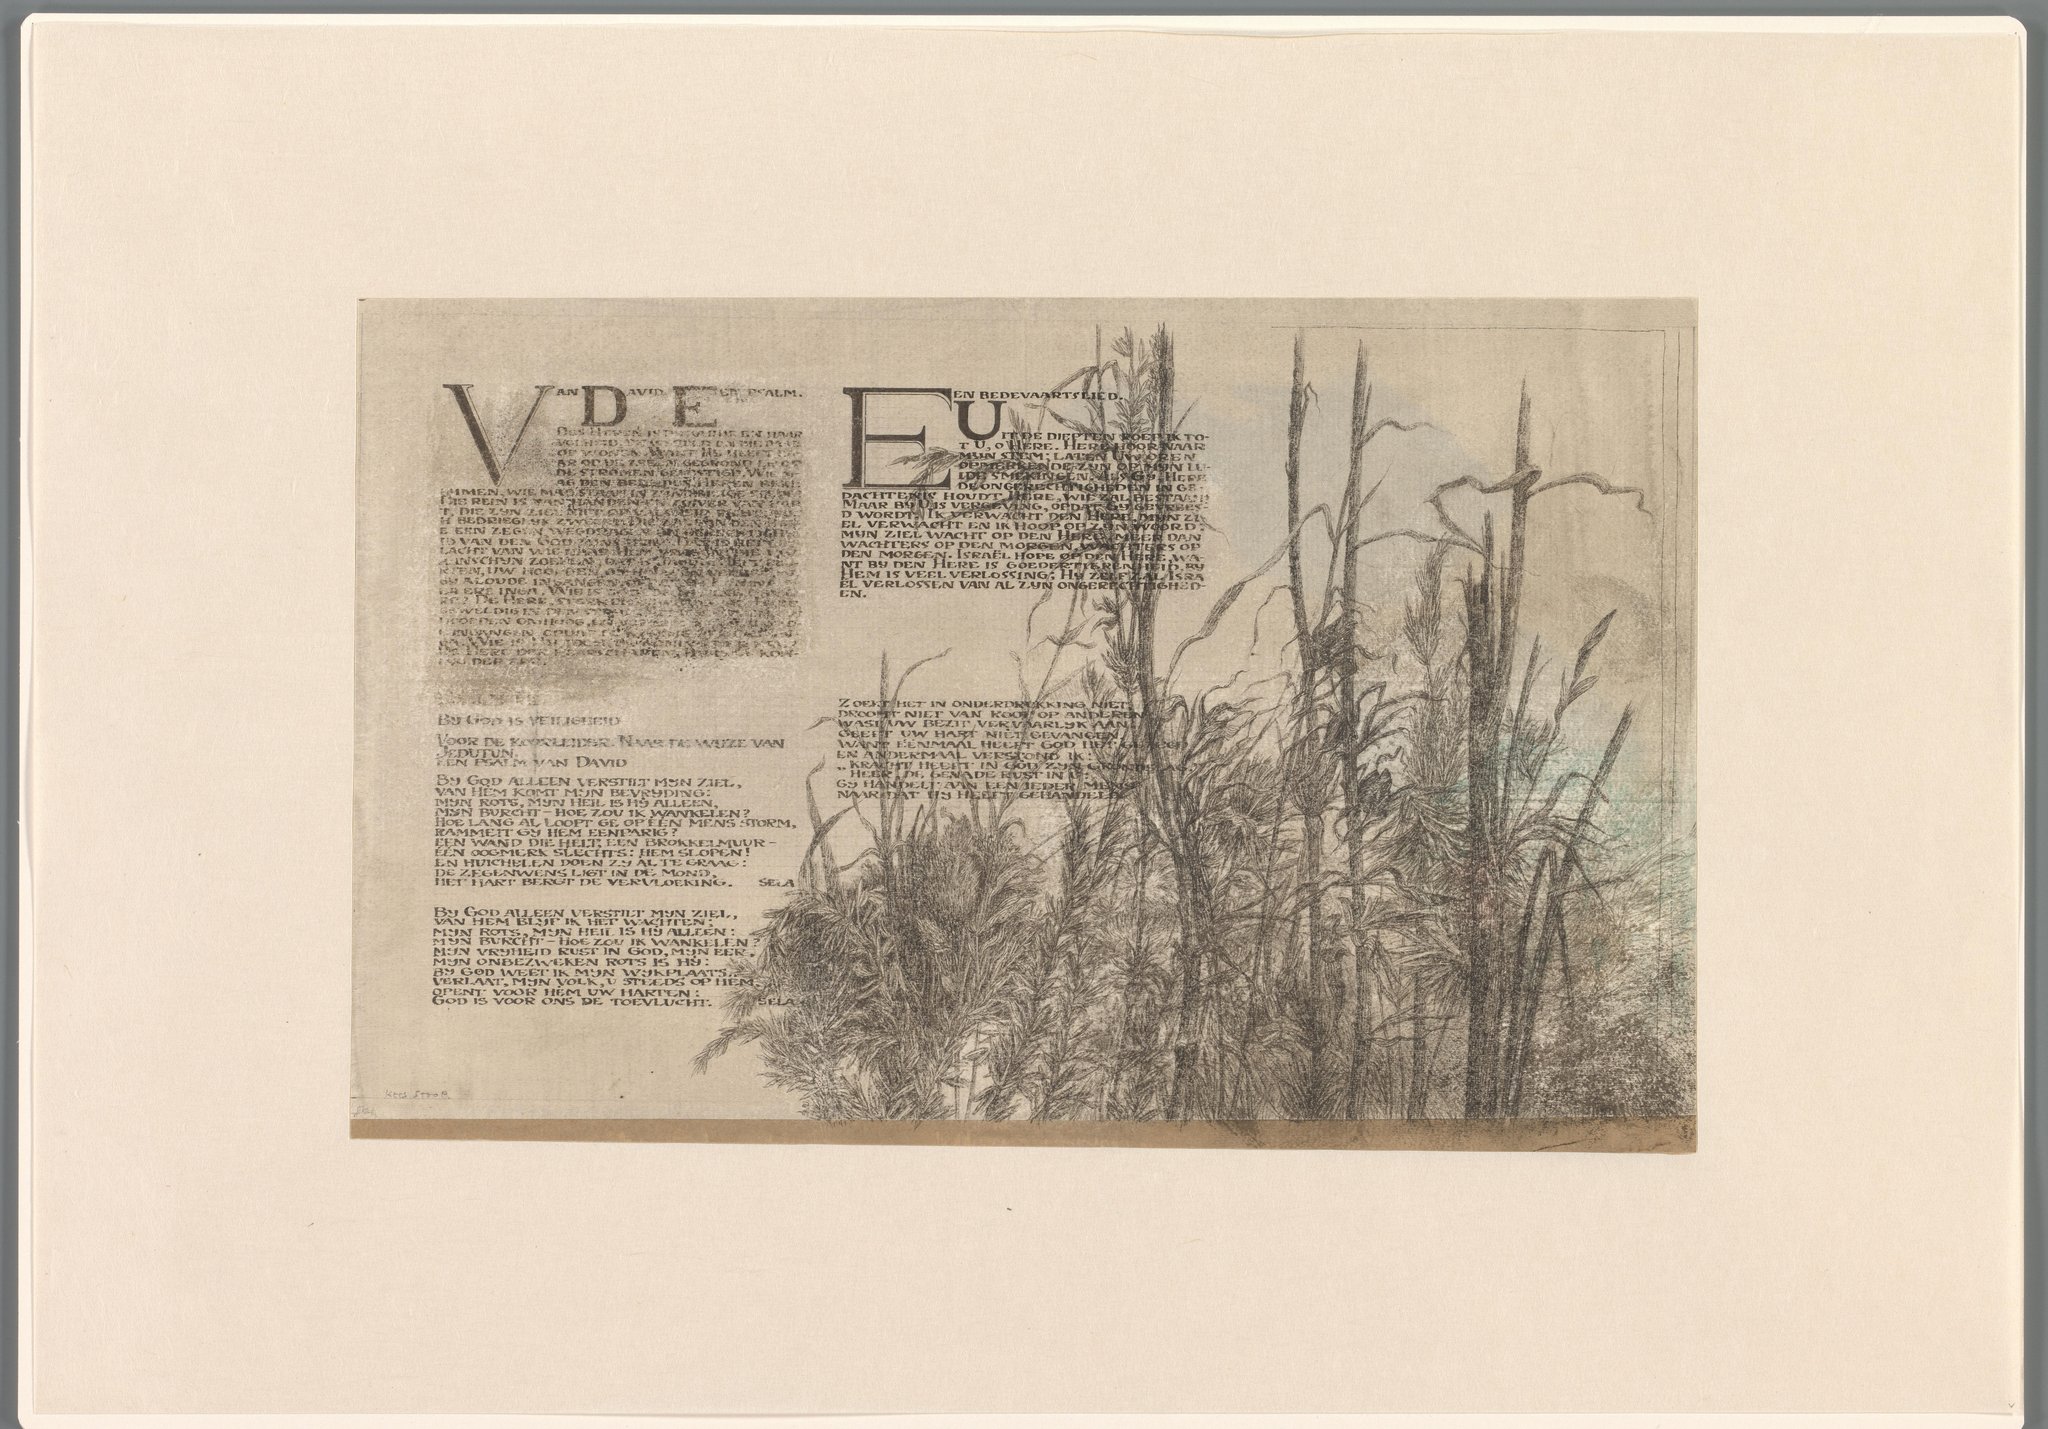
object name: drawing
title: Grashalmen en bijbelfragment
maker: kees stoop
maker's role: draughtsman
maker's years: 1929-2019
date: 1944-1990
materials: ink, paper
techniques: writing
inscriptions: signature: ‘KEES STOOP’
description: Grashalmen en bijbelfragment (Psalm van David).